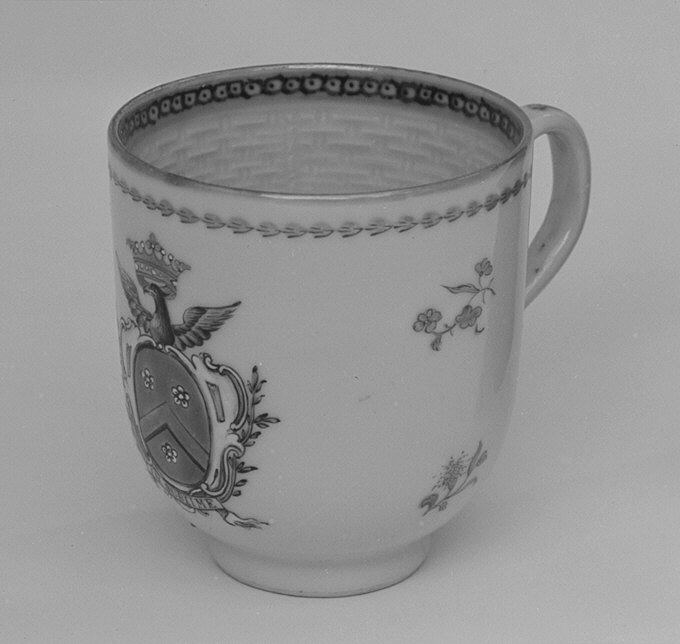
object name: cup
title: Cup (part of a service)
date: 1770-1785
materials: hard paste porcelain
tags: eagles,coat of arms